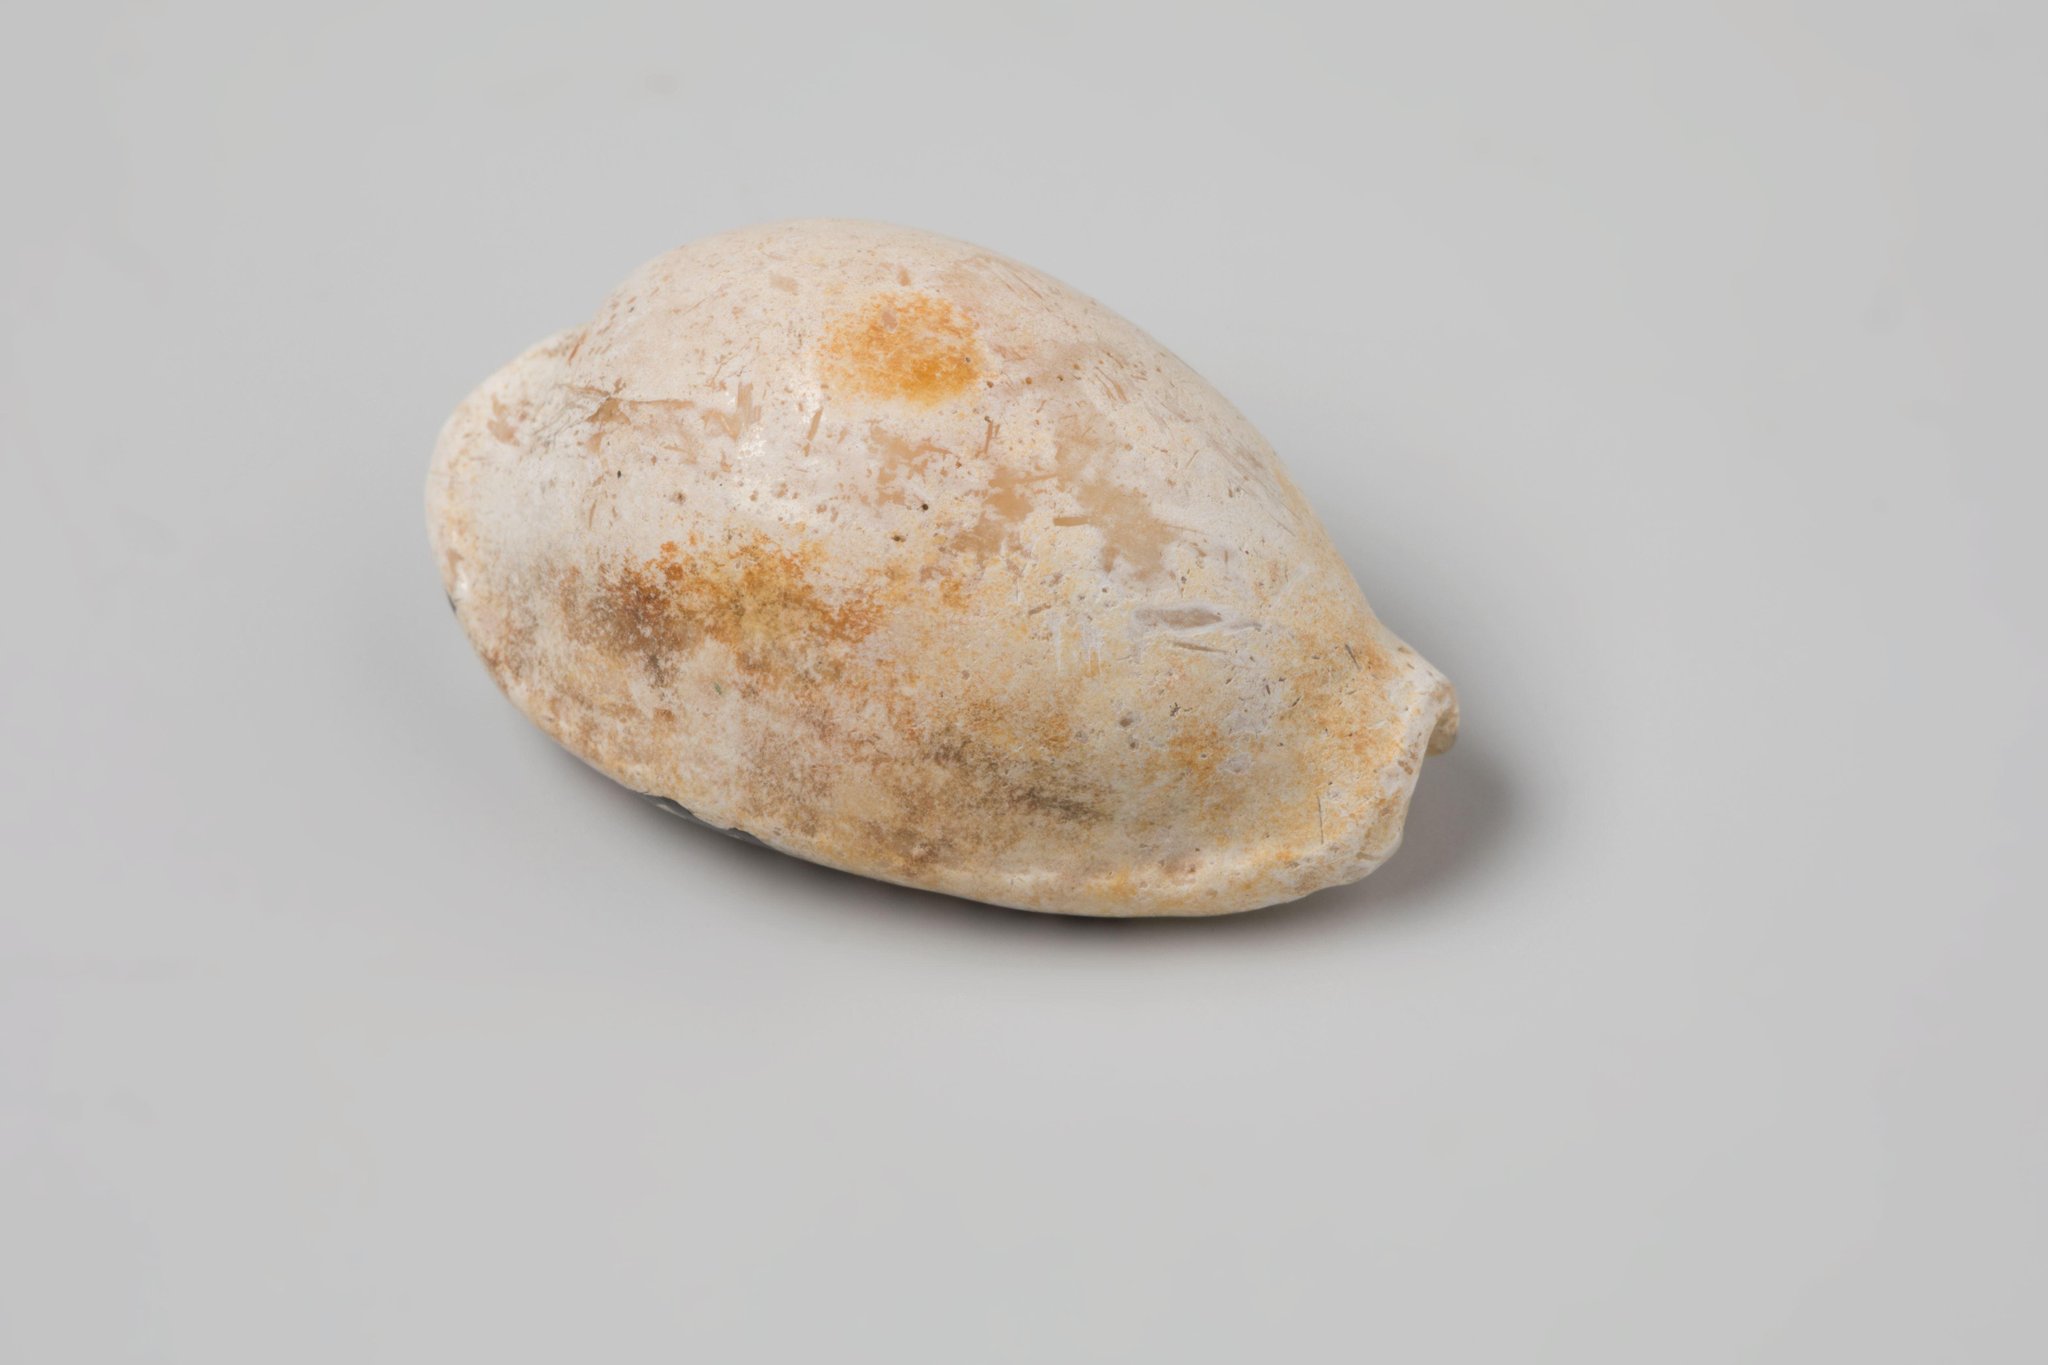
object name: erosaria spurca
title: Erosaria spurca shell from the wreck of the Dutch East India ship Witte Leeuw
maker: niet van toepassing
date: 1613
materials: shell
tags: verenigde oostindische compagnie, sint-helena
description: Schelp uit V.O.C.-schip de 'Witte Leeuw'.